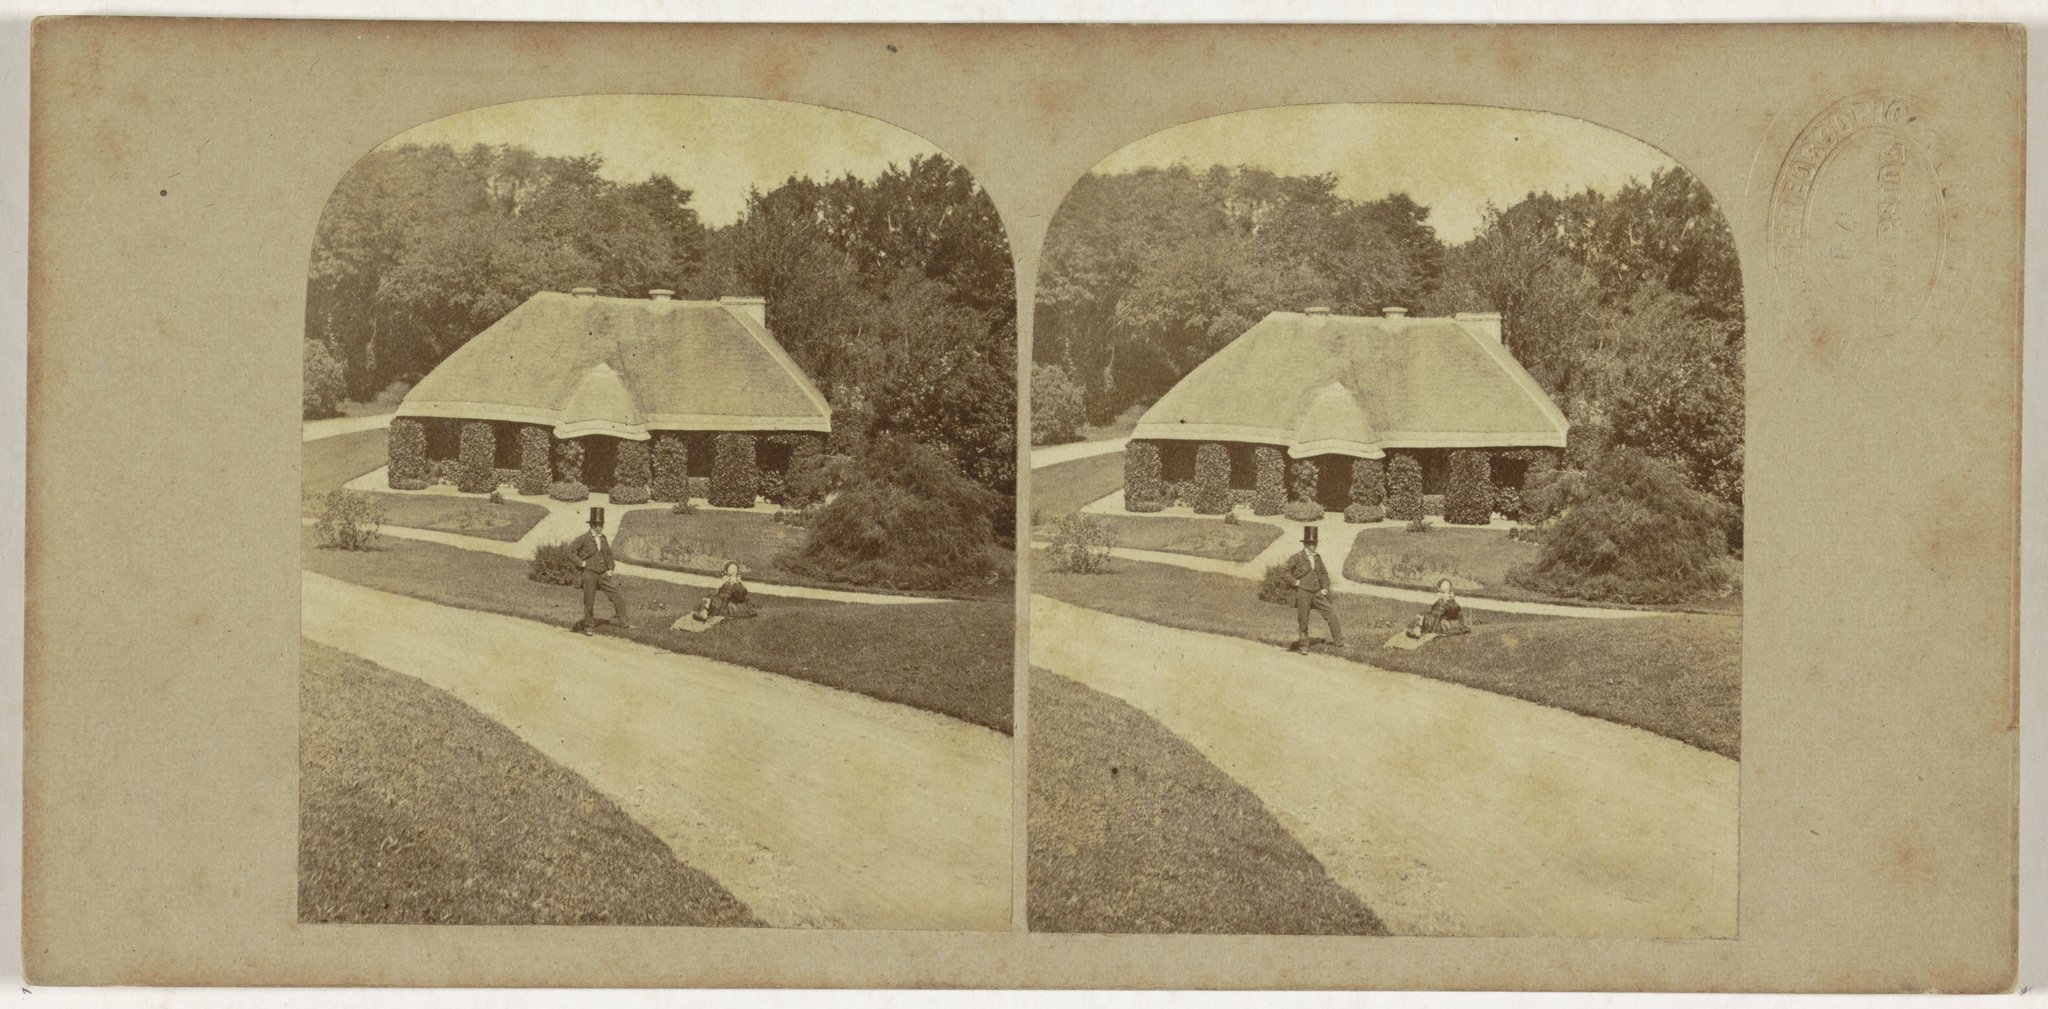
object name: stereograph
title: Huisje op het landgoed van Kenmare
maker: Anonymous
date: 1856-1922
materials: cardboard, paper, photographic support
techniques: albumen print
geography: london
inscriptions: inscription: ‘N.° 7.’, label: ‘Cottage on the Kenmare Demesne, Killarney, Ireland.’, check stamp: ‘London Stereoscopic Company / 54 Cheapside’, name: ‘H. Ameschot.’